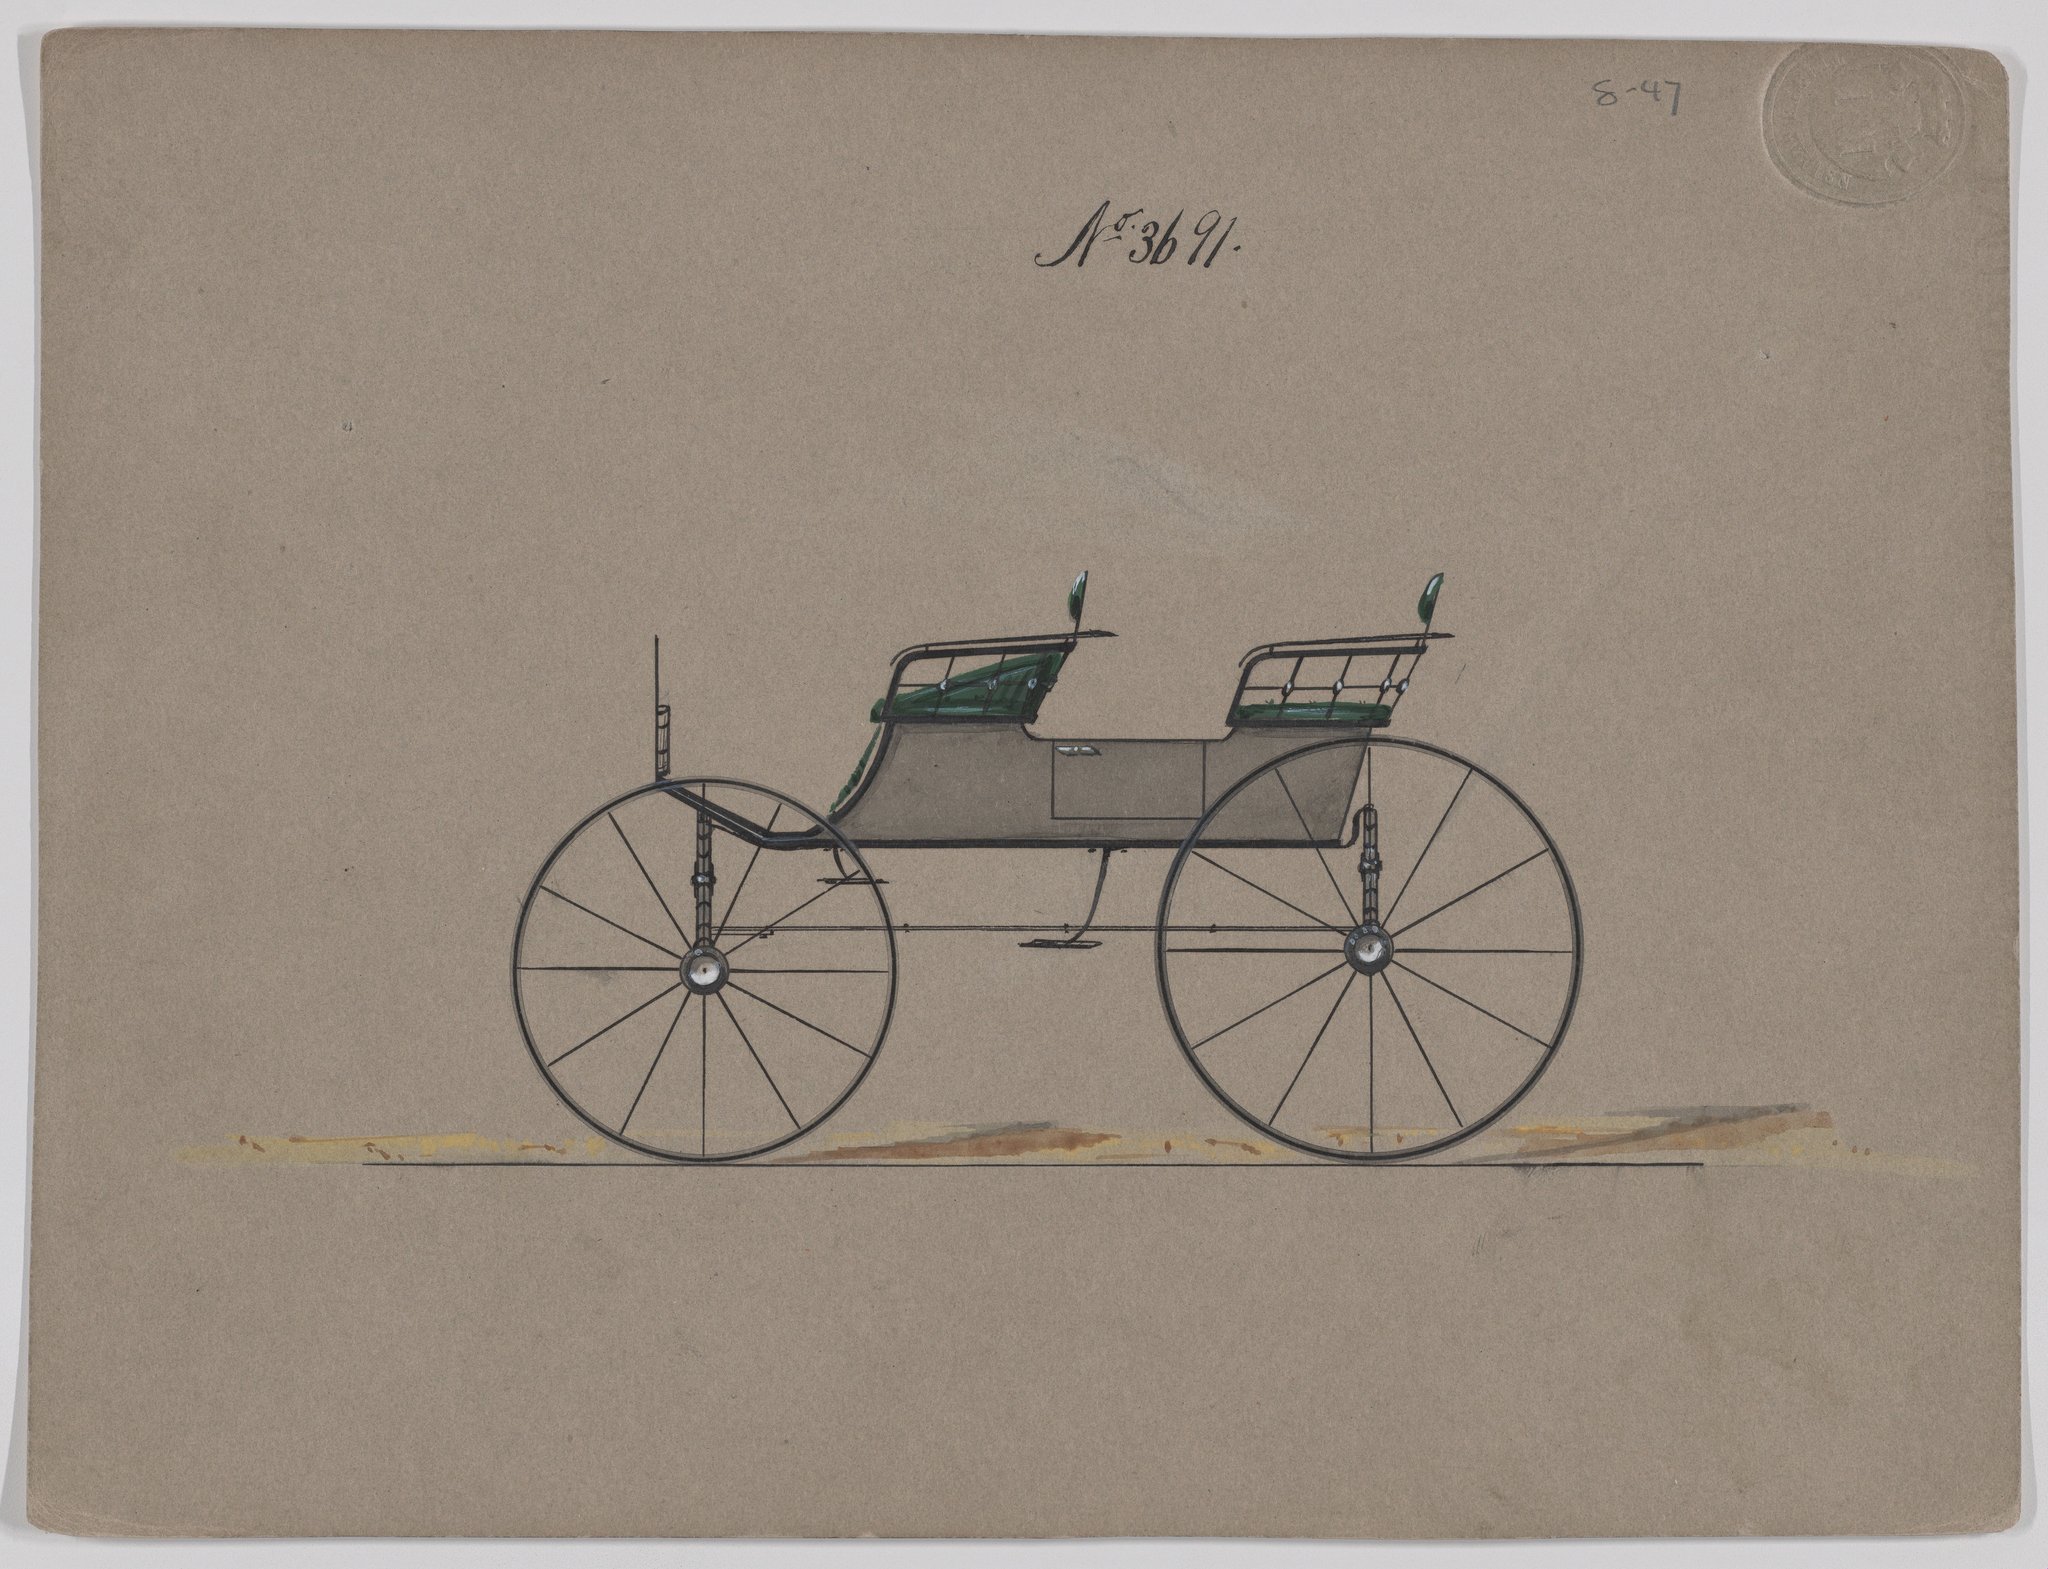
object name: drawing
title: Design for 4 seat Phaeton, no top, no. 3691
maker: brewster & co.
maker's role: manufacturer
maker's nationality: american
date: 1881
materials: gouache, ink, watercolor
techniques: pen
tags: carriages